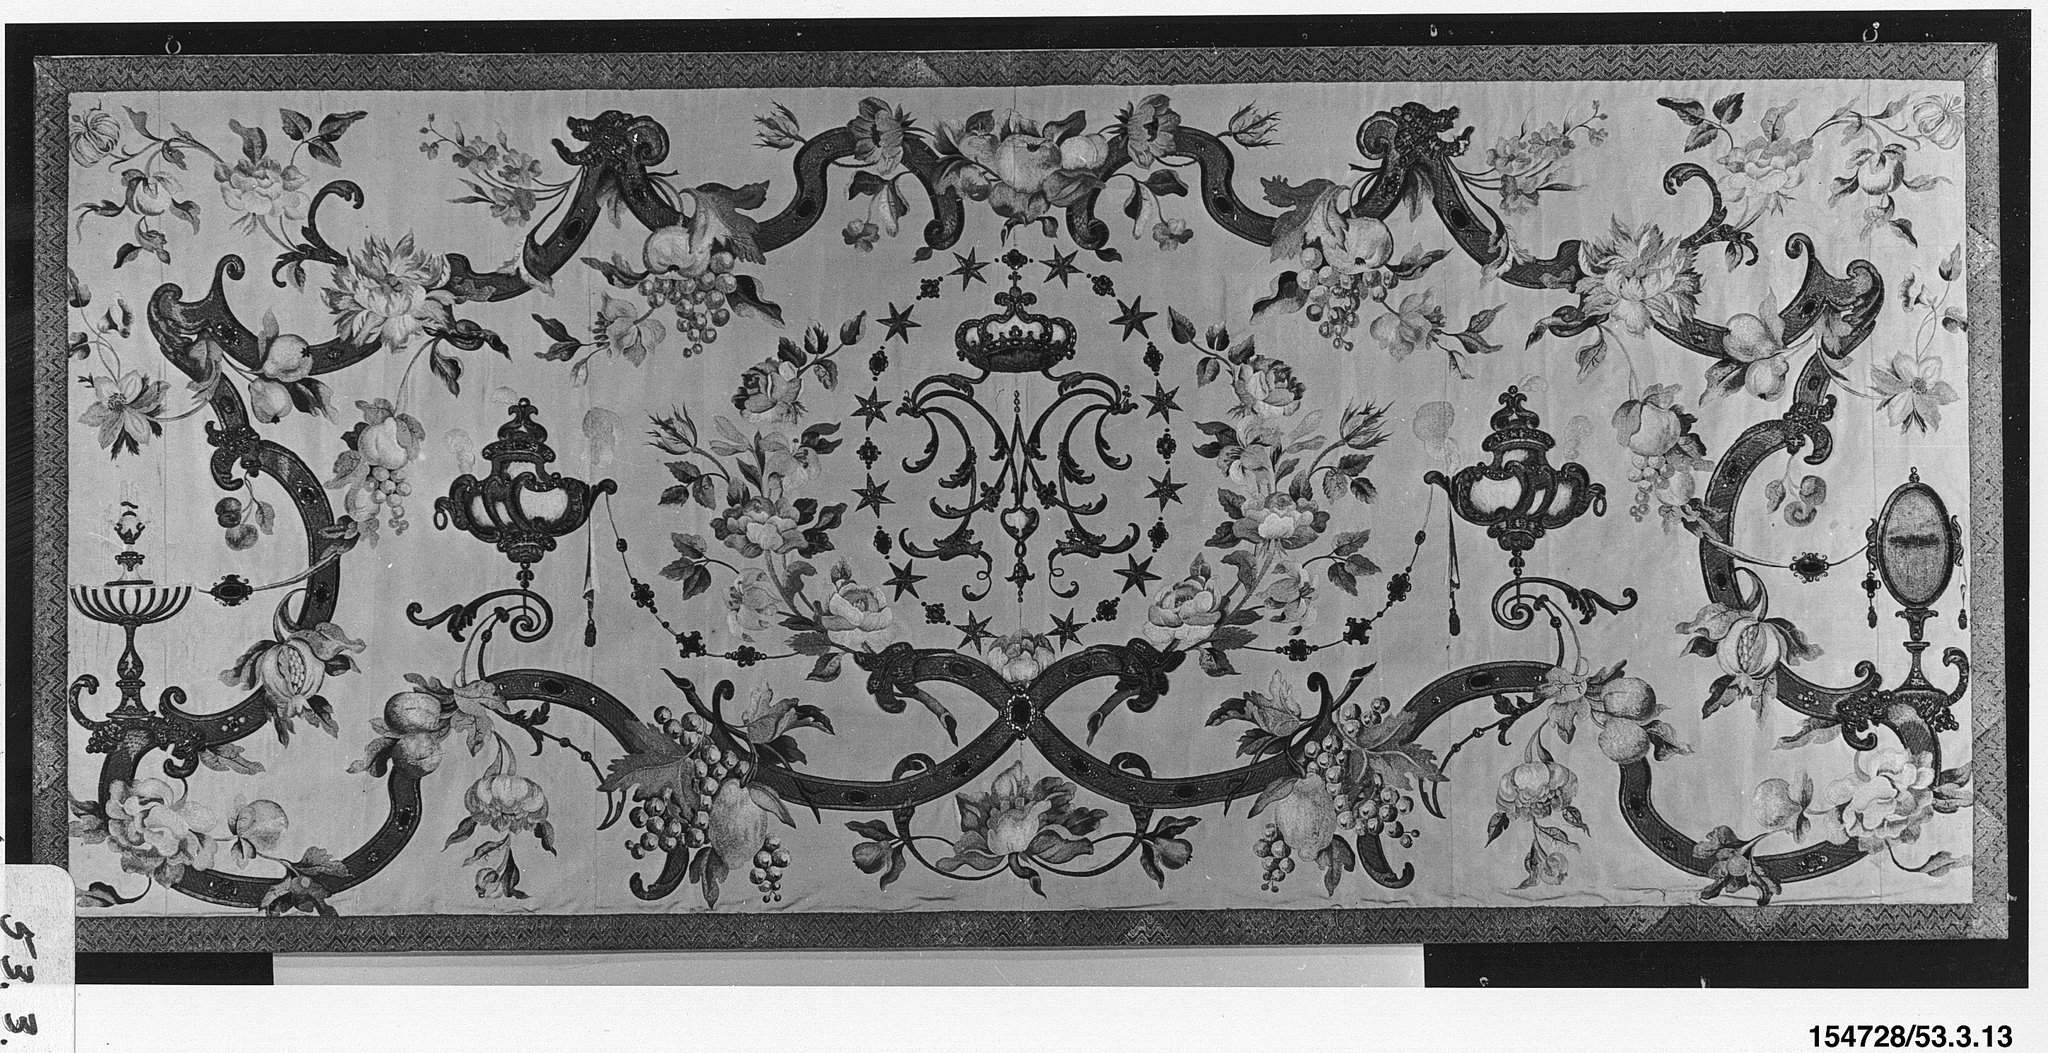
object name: altar frontal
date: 1701-1733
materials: metal thread, silk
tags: grapes,flowers,leaves